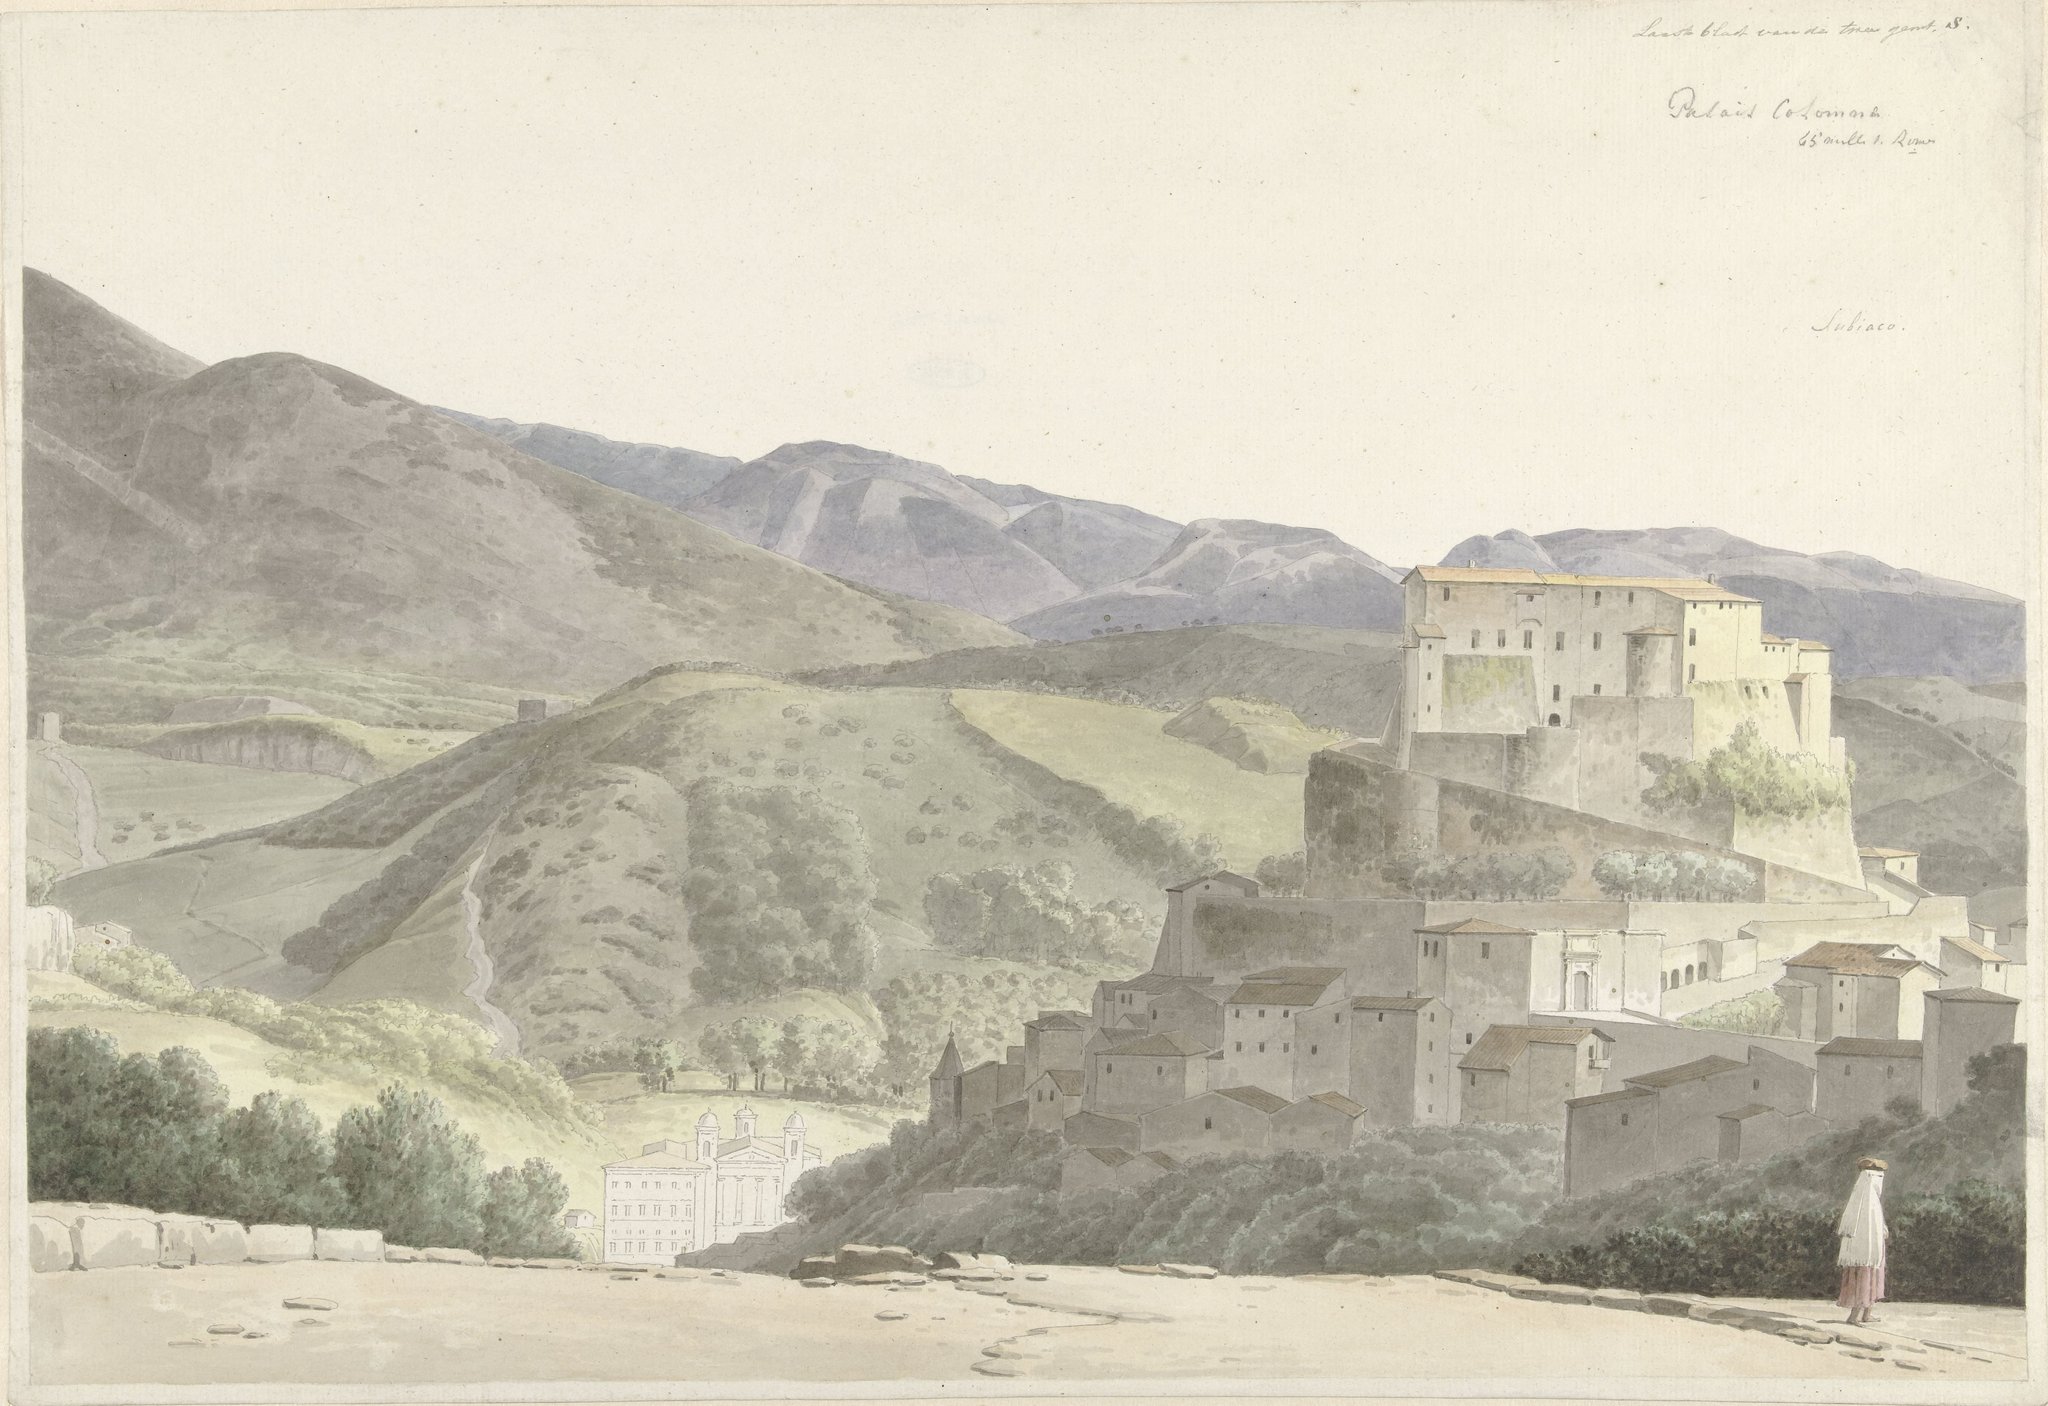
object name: drawing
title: Italiaans landschap bij Subiaco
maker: josephus augustus knip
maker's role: draughtsman, painter, print maker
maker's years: 1777-1847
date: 1787-1847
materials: ink, paper, pencil, watercolor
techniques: brush, pen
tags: landscapes in the temperate zone, italy